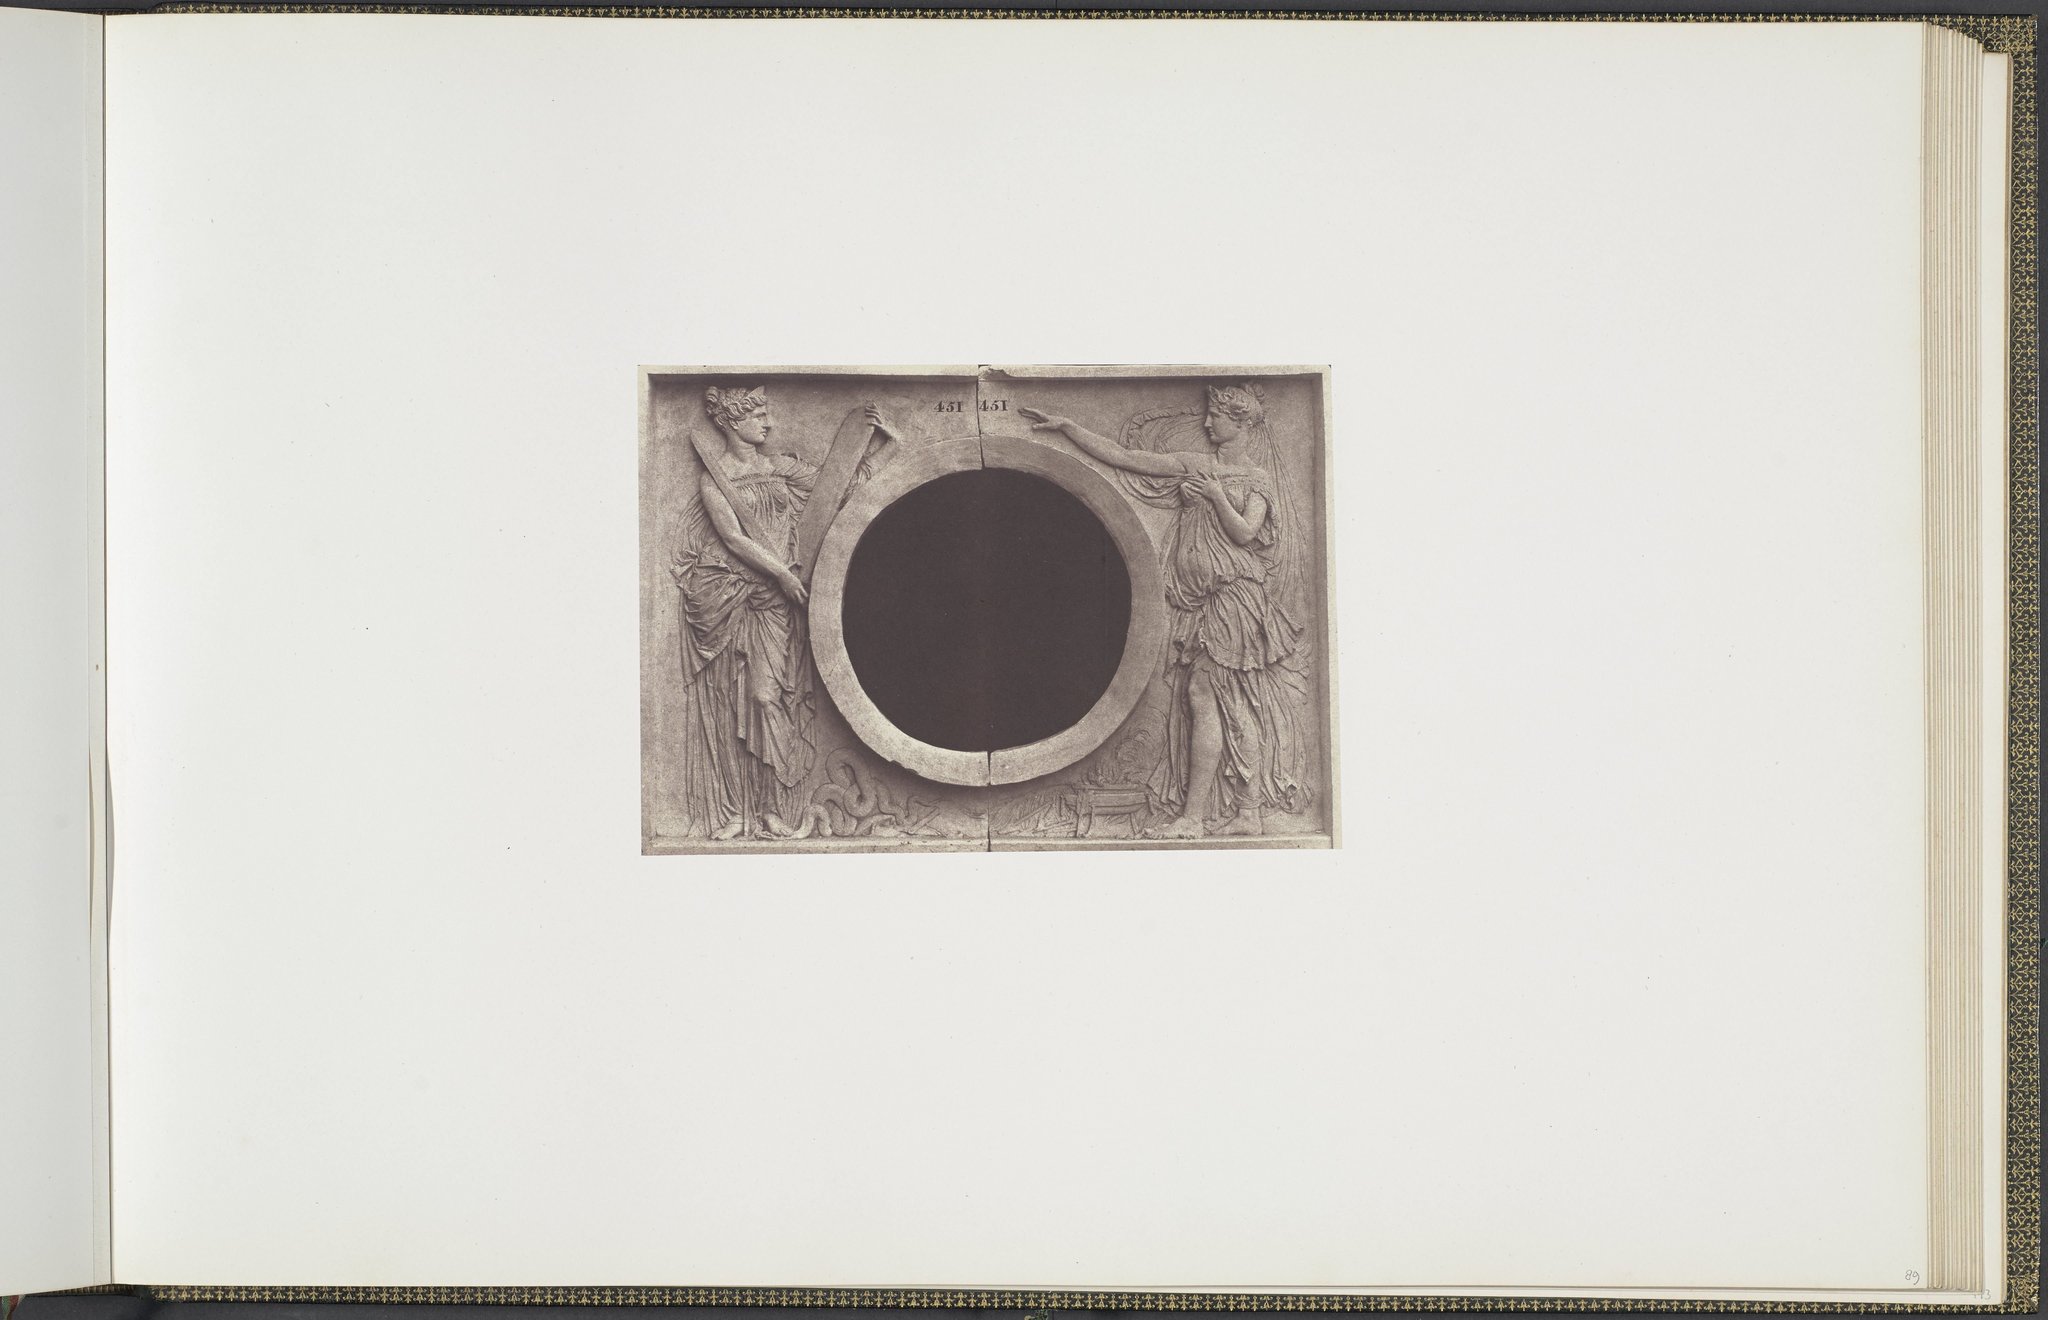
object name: photograph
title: Gipsmodellen voor beeldhouwwerken op het Palais du Louvre: "La Justice et la Fraternité" door Joseph Félon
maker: édouard denis baldus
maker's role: fotograaf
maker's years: 1813-1889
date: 1855-1857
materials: paper, photographic support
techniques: salted paper print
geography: paris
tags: piece of sculpture, reproduction of a piece of sculpture, permanent exhibition, museum, paris, tuileries palace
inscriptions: number: ‘451’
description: Onderdeel van Réunion des Tuileries au Louvre 1852-1857, album 1.